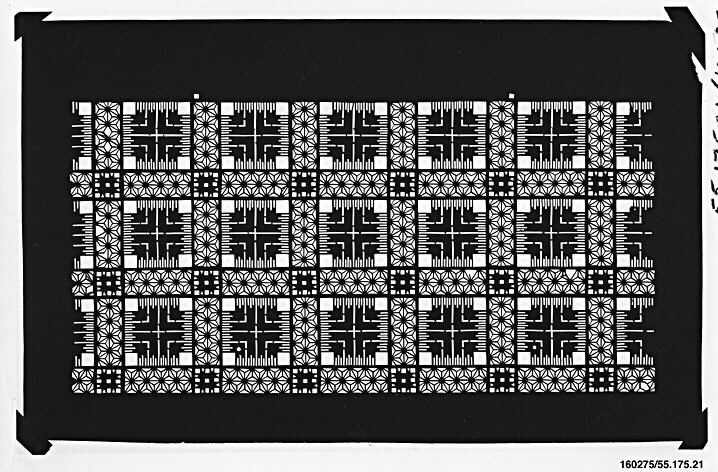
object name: stencil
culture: japanese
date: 1801-1900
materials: paper